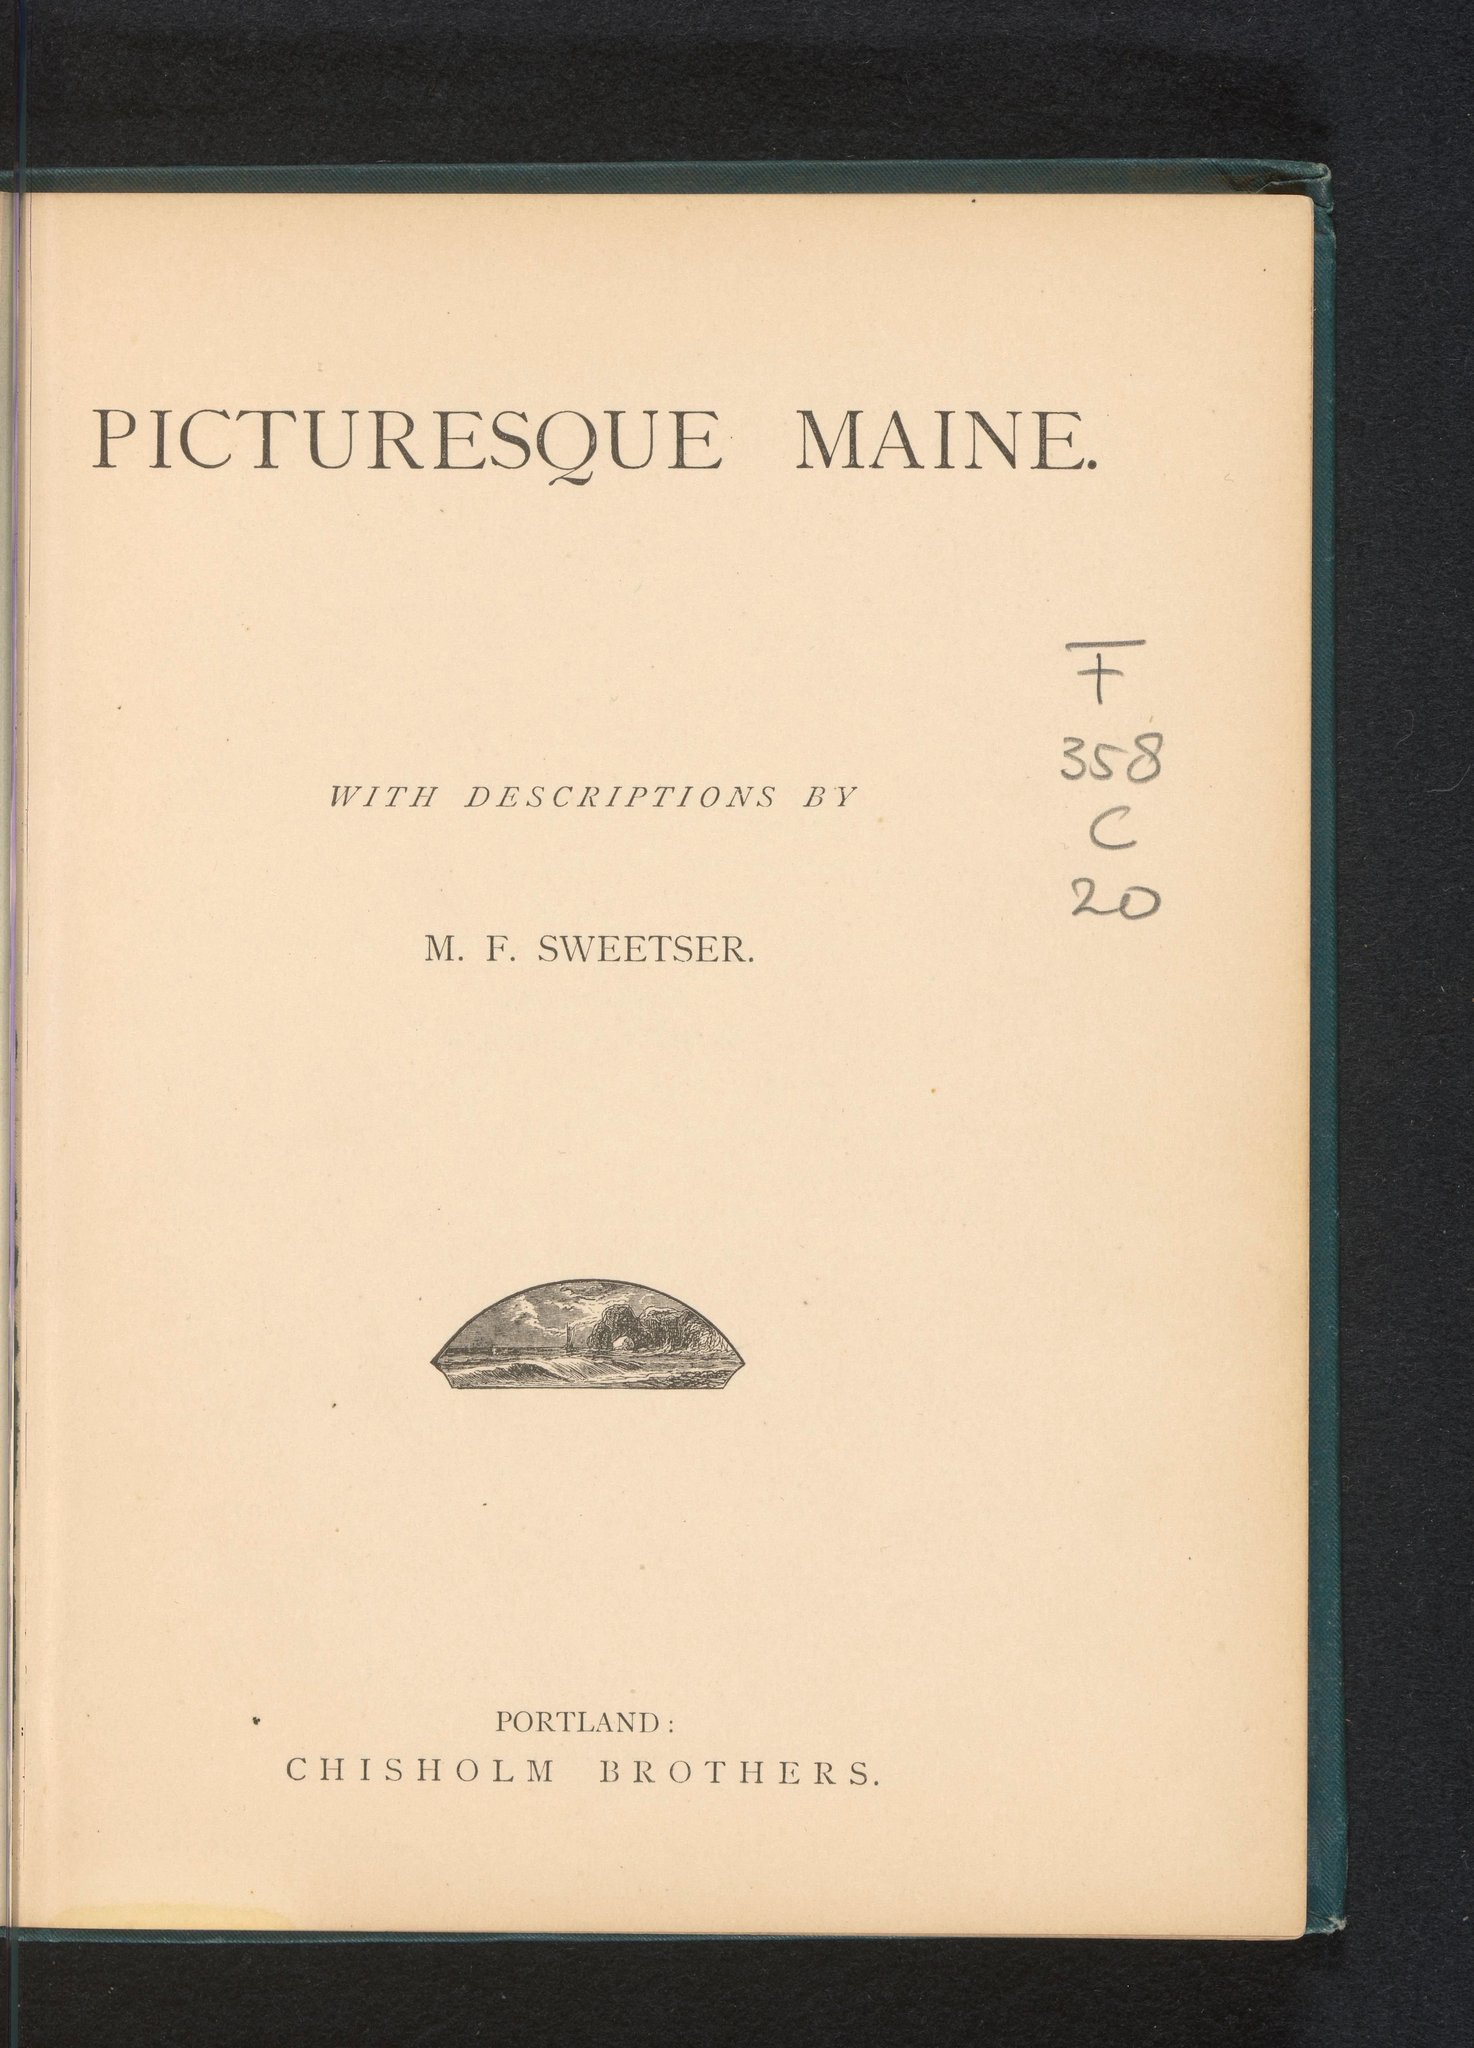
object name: book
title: Picturesque Maine/ with descriptions by M.F. Sweetser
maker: moses forster sweetser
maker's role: auteur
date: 1880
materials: cardboard, linen, paper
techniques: photograph, printing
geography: portland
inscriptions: annotation: ‘26/ photos/ on/ 24 plates/ complete’, annotation: ‘oct 1998/ D[...]’